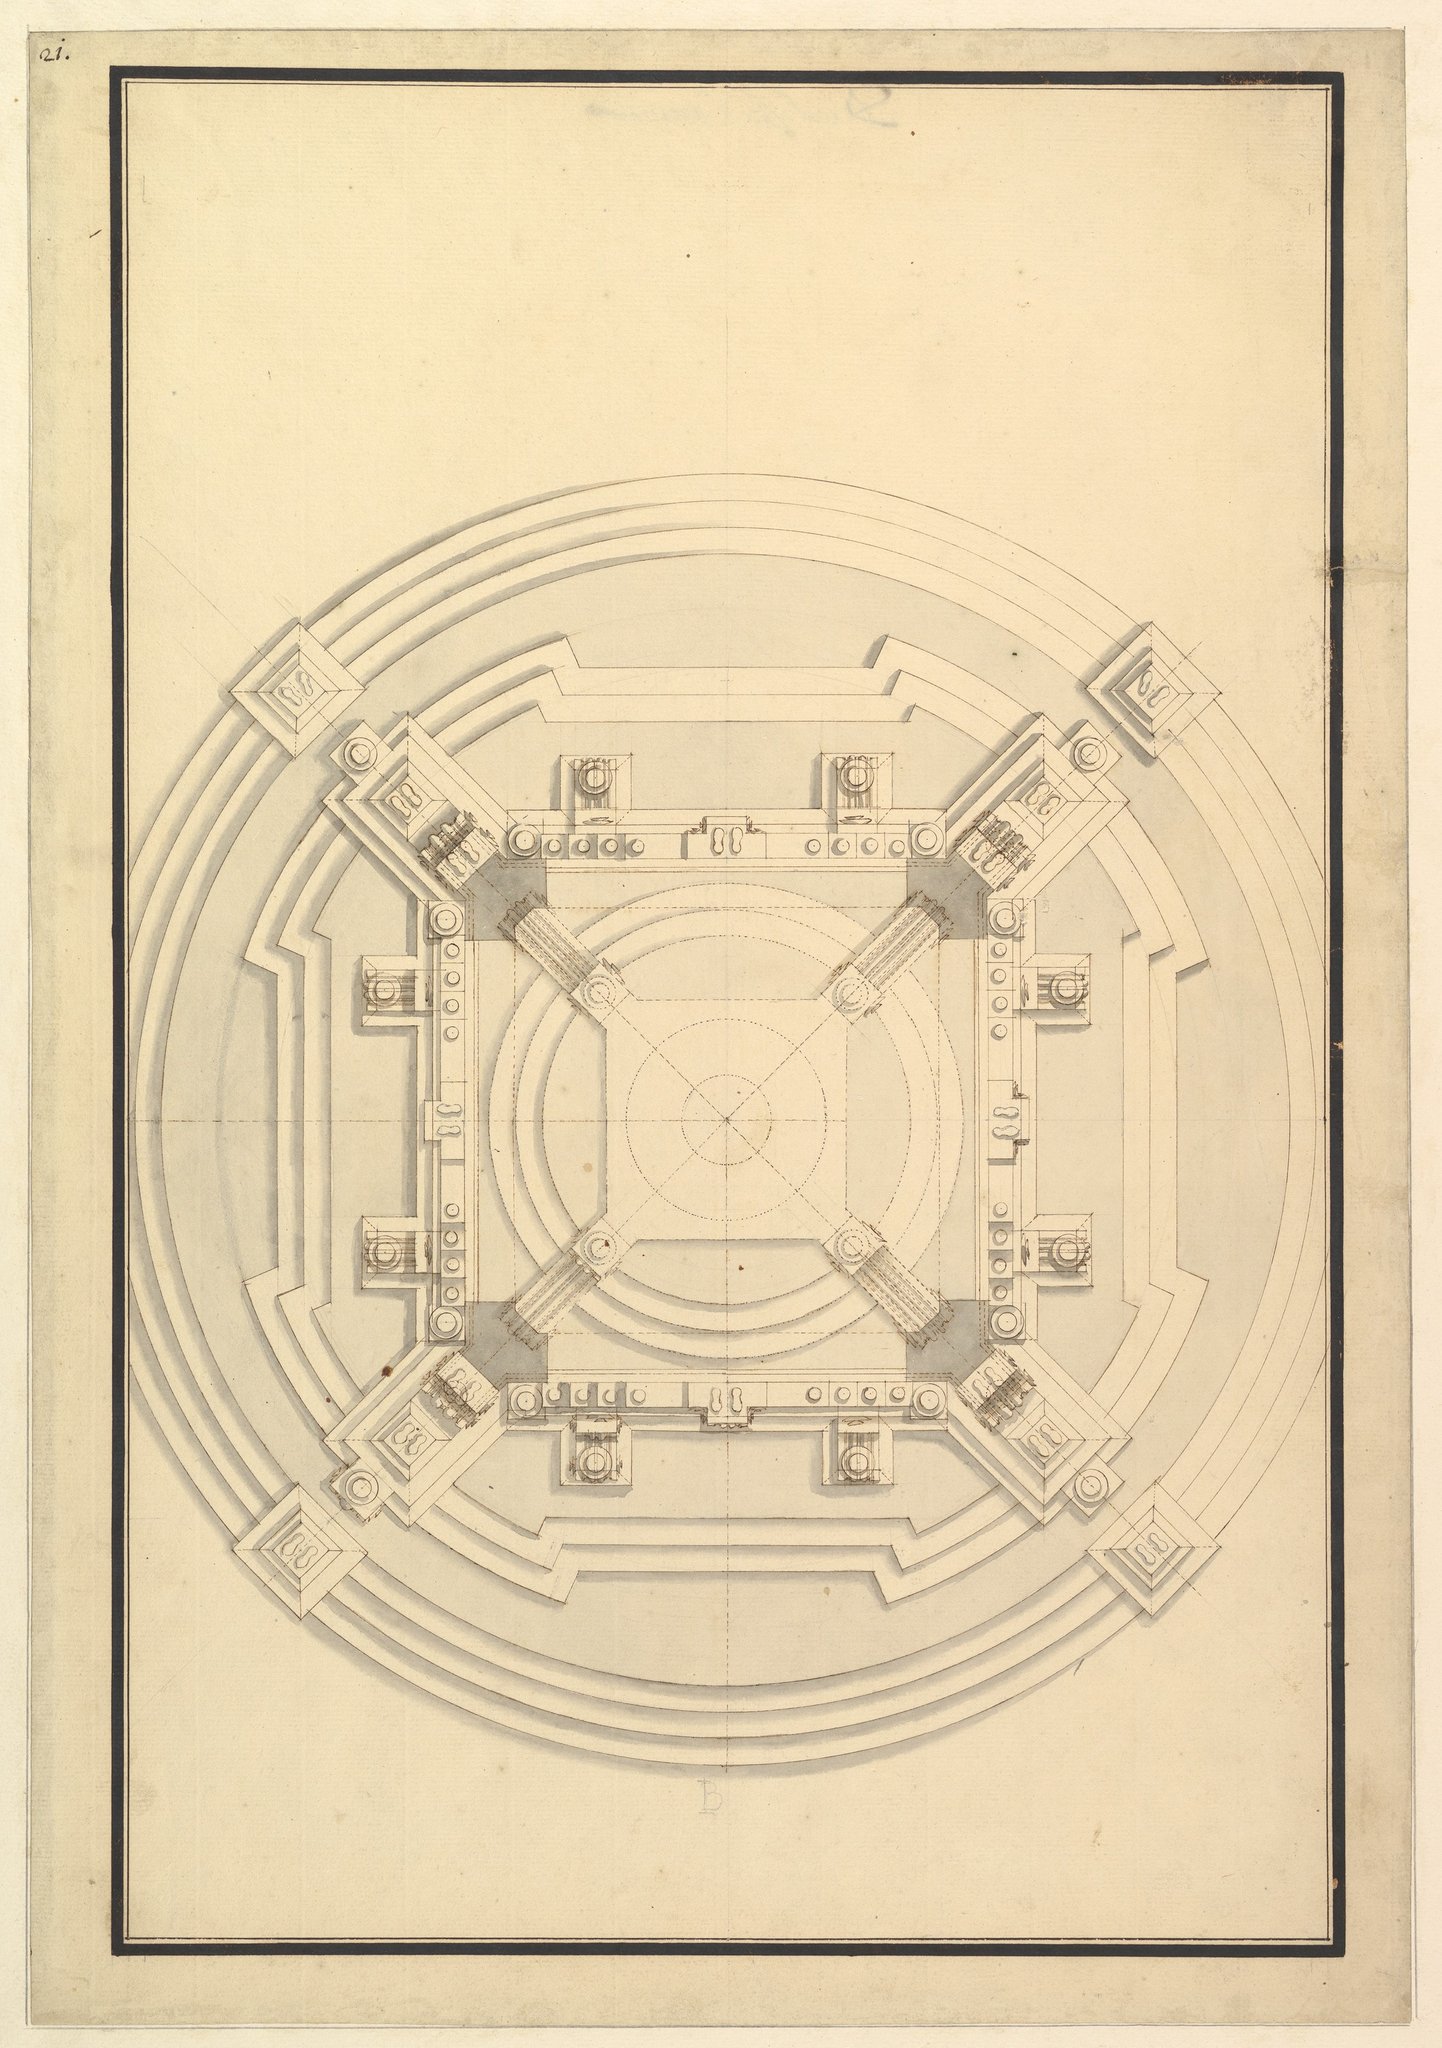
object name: drawing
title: Ground Plan for a Catafalque for a Duchess of Hanover, probably Sophia (1630–1714), the mother of George I of England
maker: giuseppe galli bibiena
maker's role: artist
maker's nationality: italian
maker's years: 1696-1756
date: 1696-1756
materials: ink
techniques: brush, pen, wash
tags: architecture